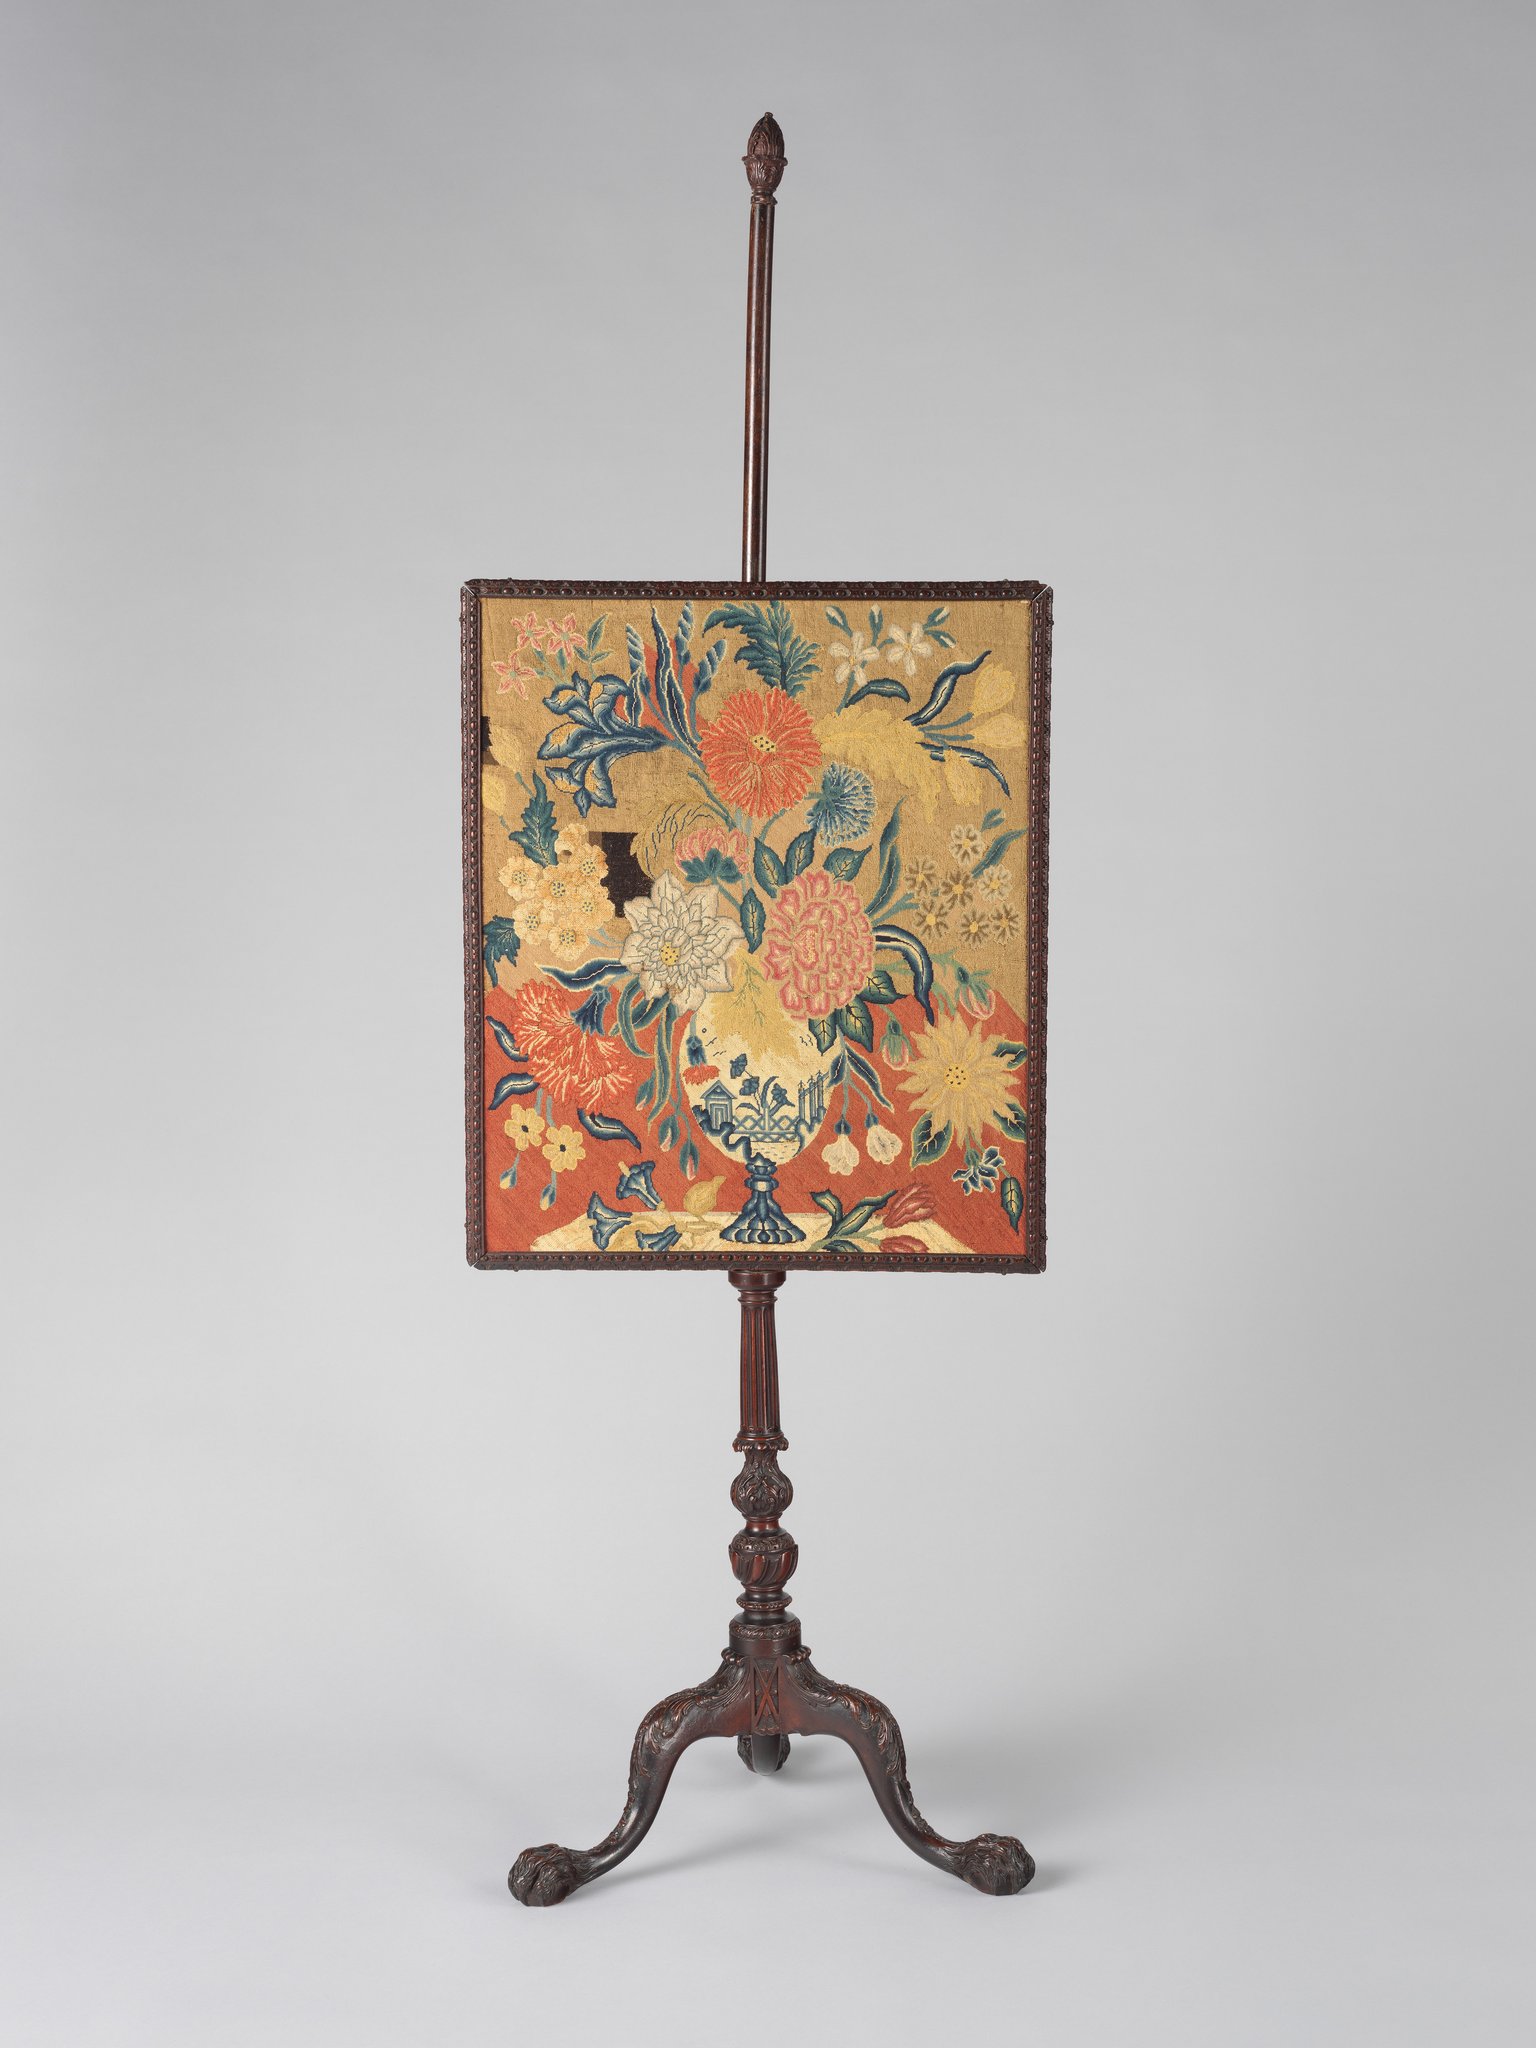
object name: firescreen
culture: american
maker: thomas affleck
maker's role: maker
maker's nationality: american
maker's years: 1740-1795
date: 1771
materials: brass, wood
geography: united states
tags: flowers